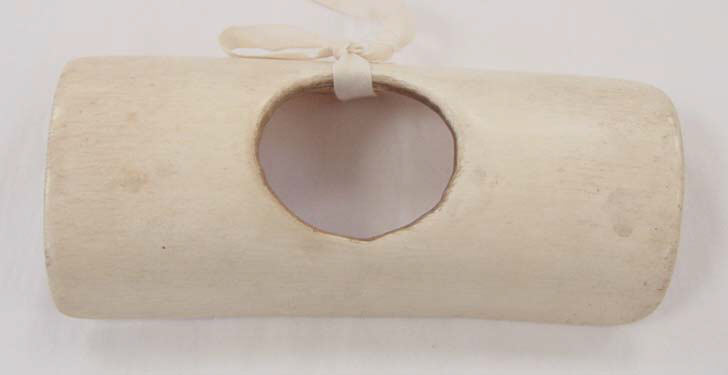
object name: bracelet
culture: african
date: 1801-1900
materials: ivory